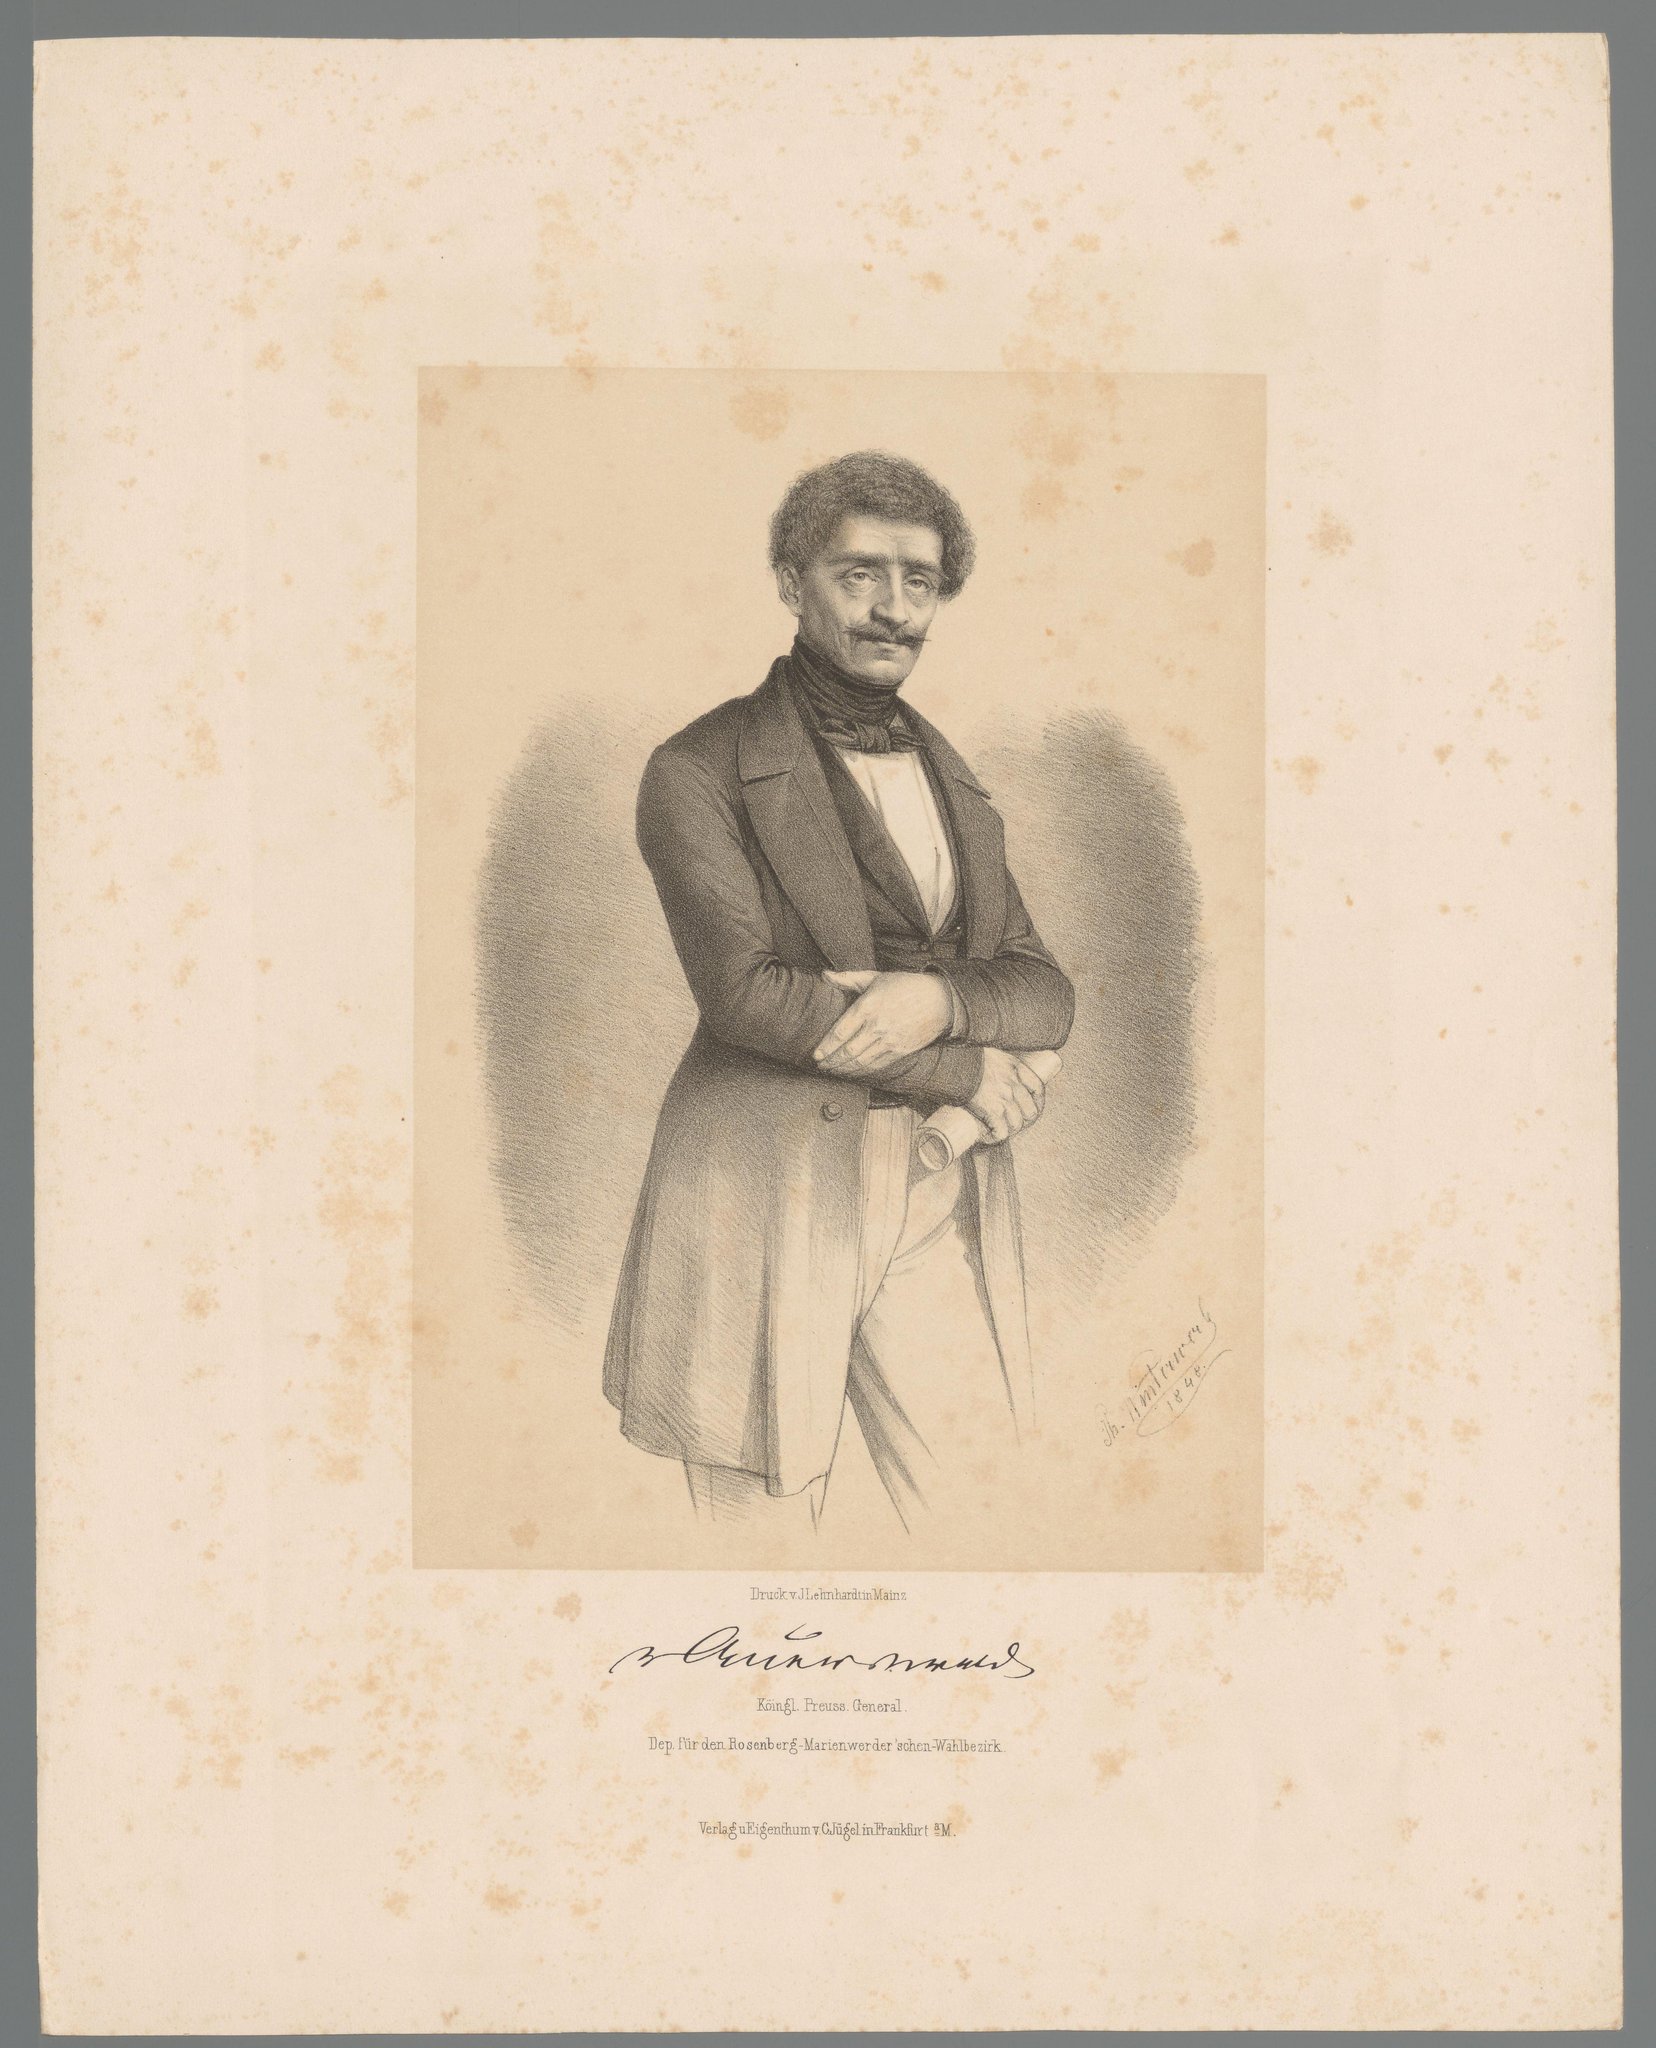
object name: print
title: Portret van Hans Adolf Erdmann von Auerswald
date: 1849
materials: paper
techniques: tone lithography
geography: mainz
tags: moustache, adult man, historical persons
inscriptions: collector's mark: Lugt 2228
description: Prent behoort waarschijnlijk tot de serie 'Album der deutschen National-Versammlung'. Deze serie bestaat uit circa 54 portretten die onder andere zijn vervaardigd door Philipp Winterwerb en Heinrich Hasselhorst naar foto's van Seib. Deze serie is in 1849 uitgegeven door Carl Christian Jügel.